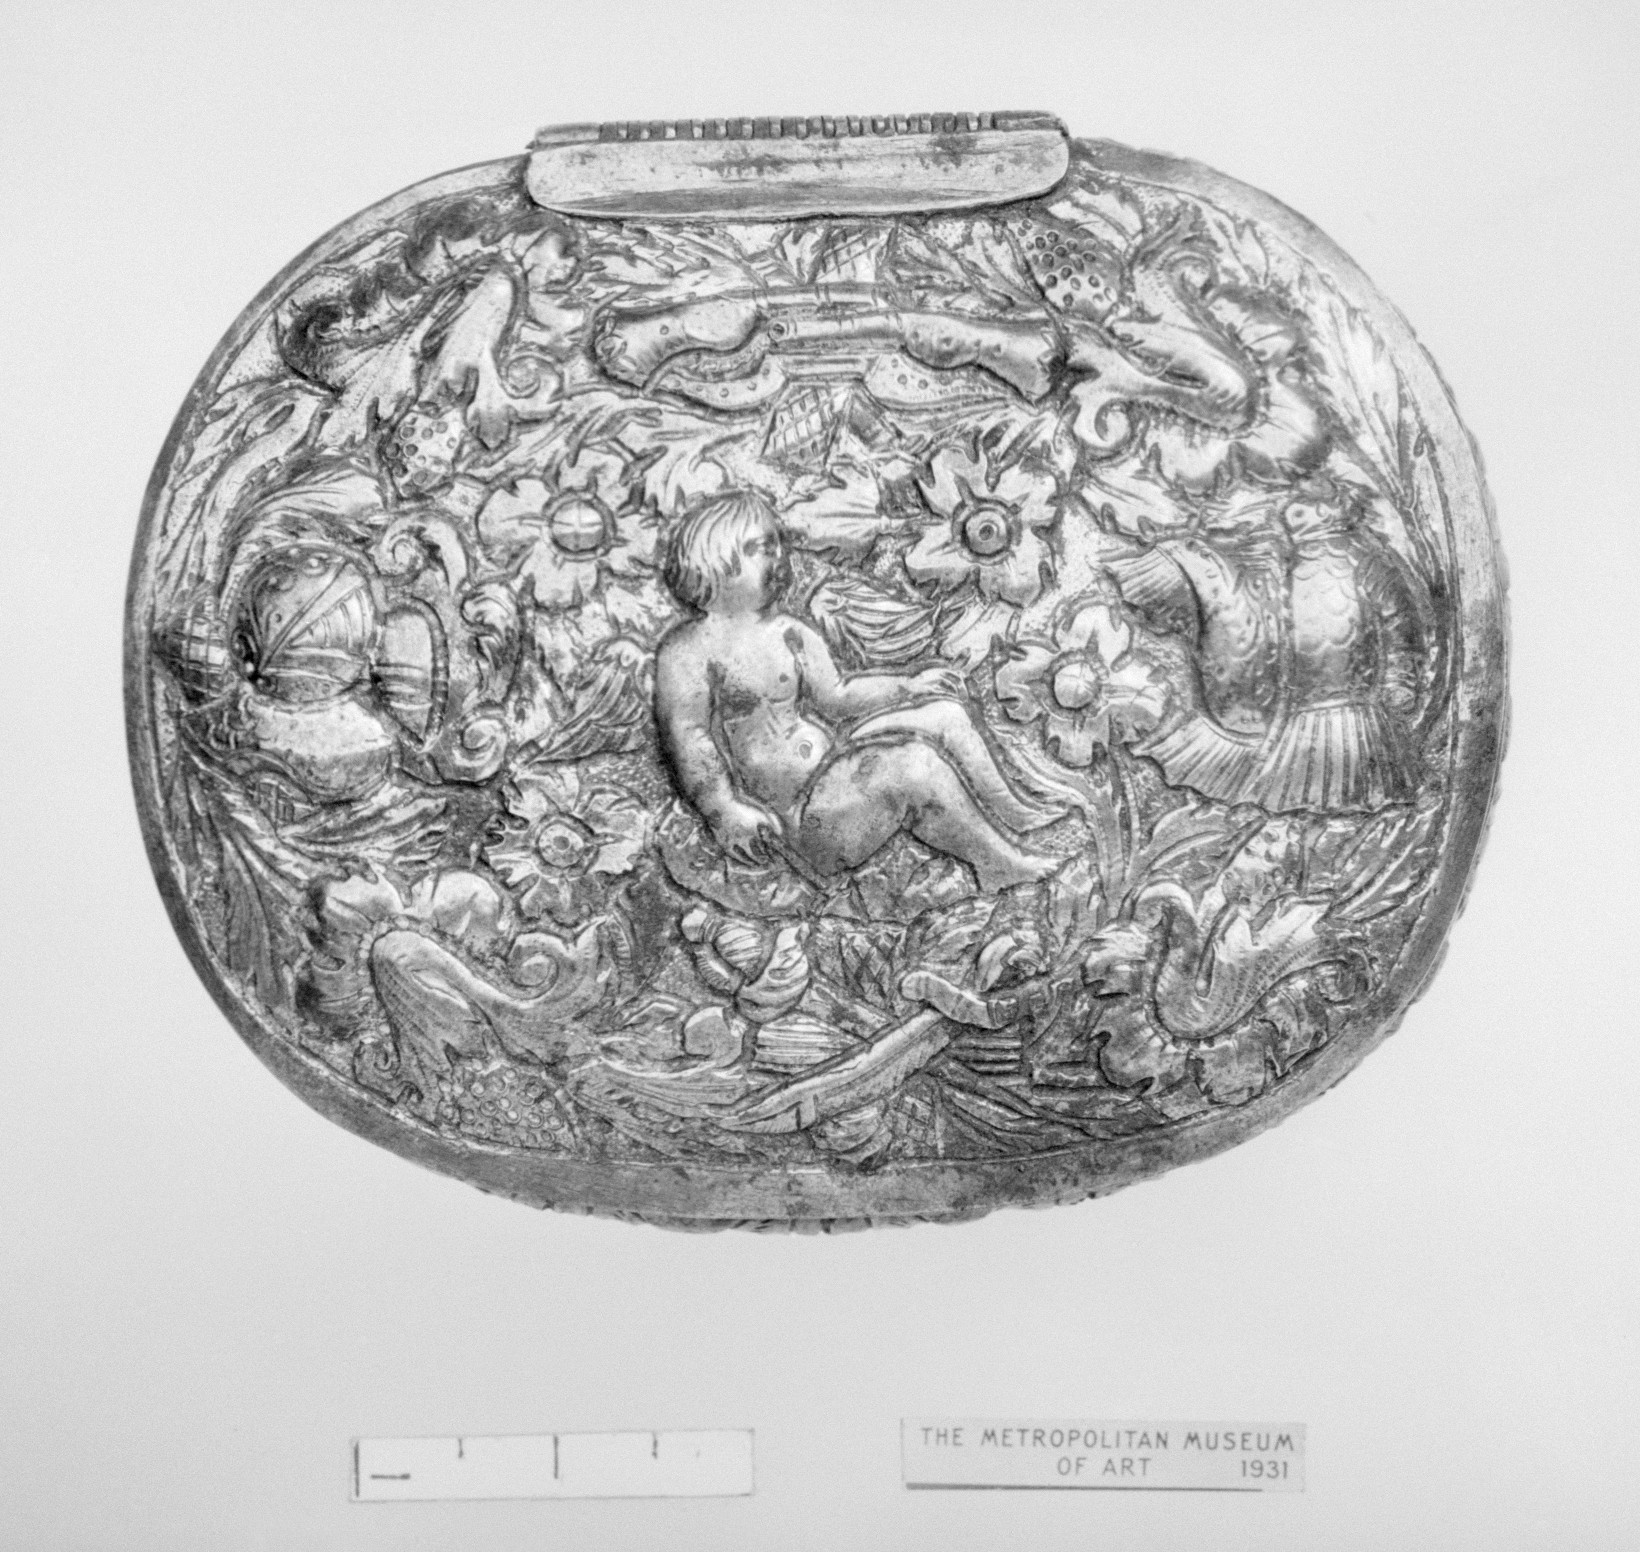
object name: box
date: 1601-1700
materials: glass, silver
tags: infants,flowers